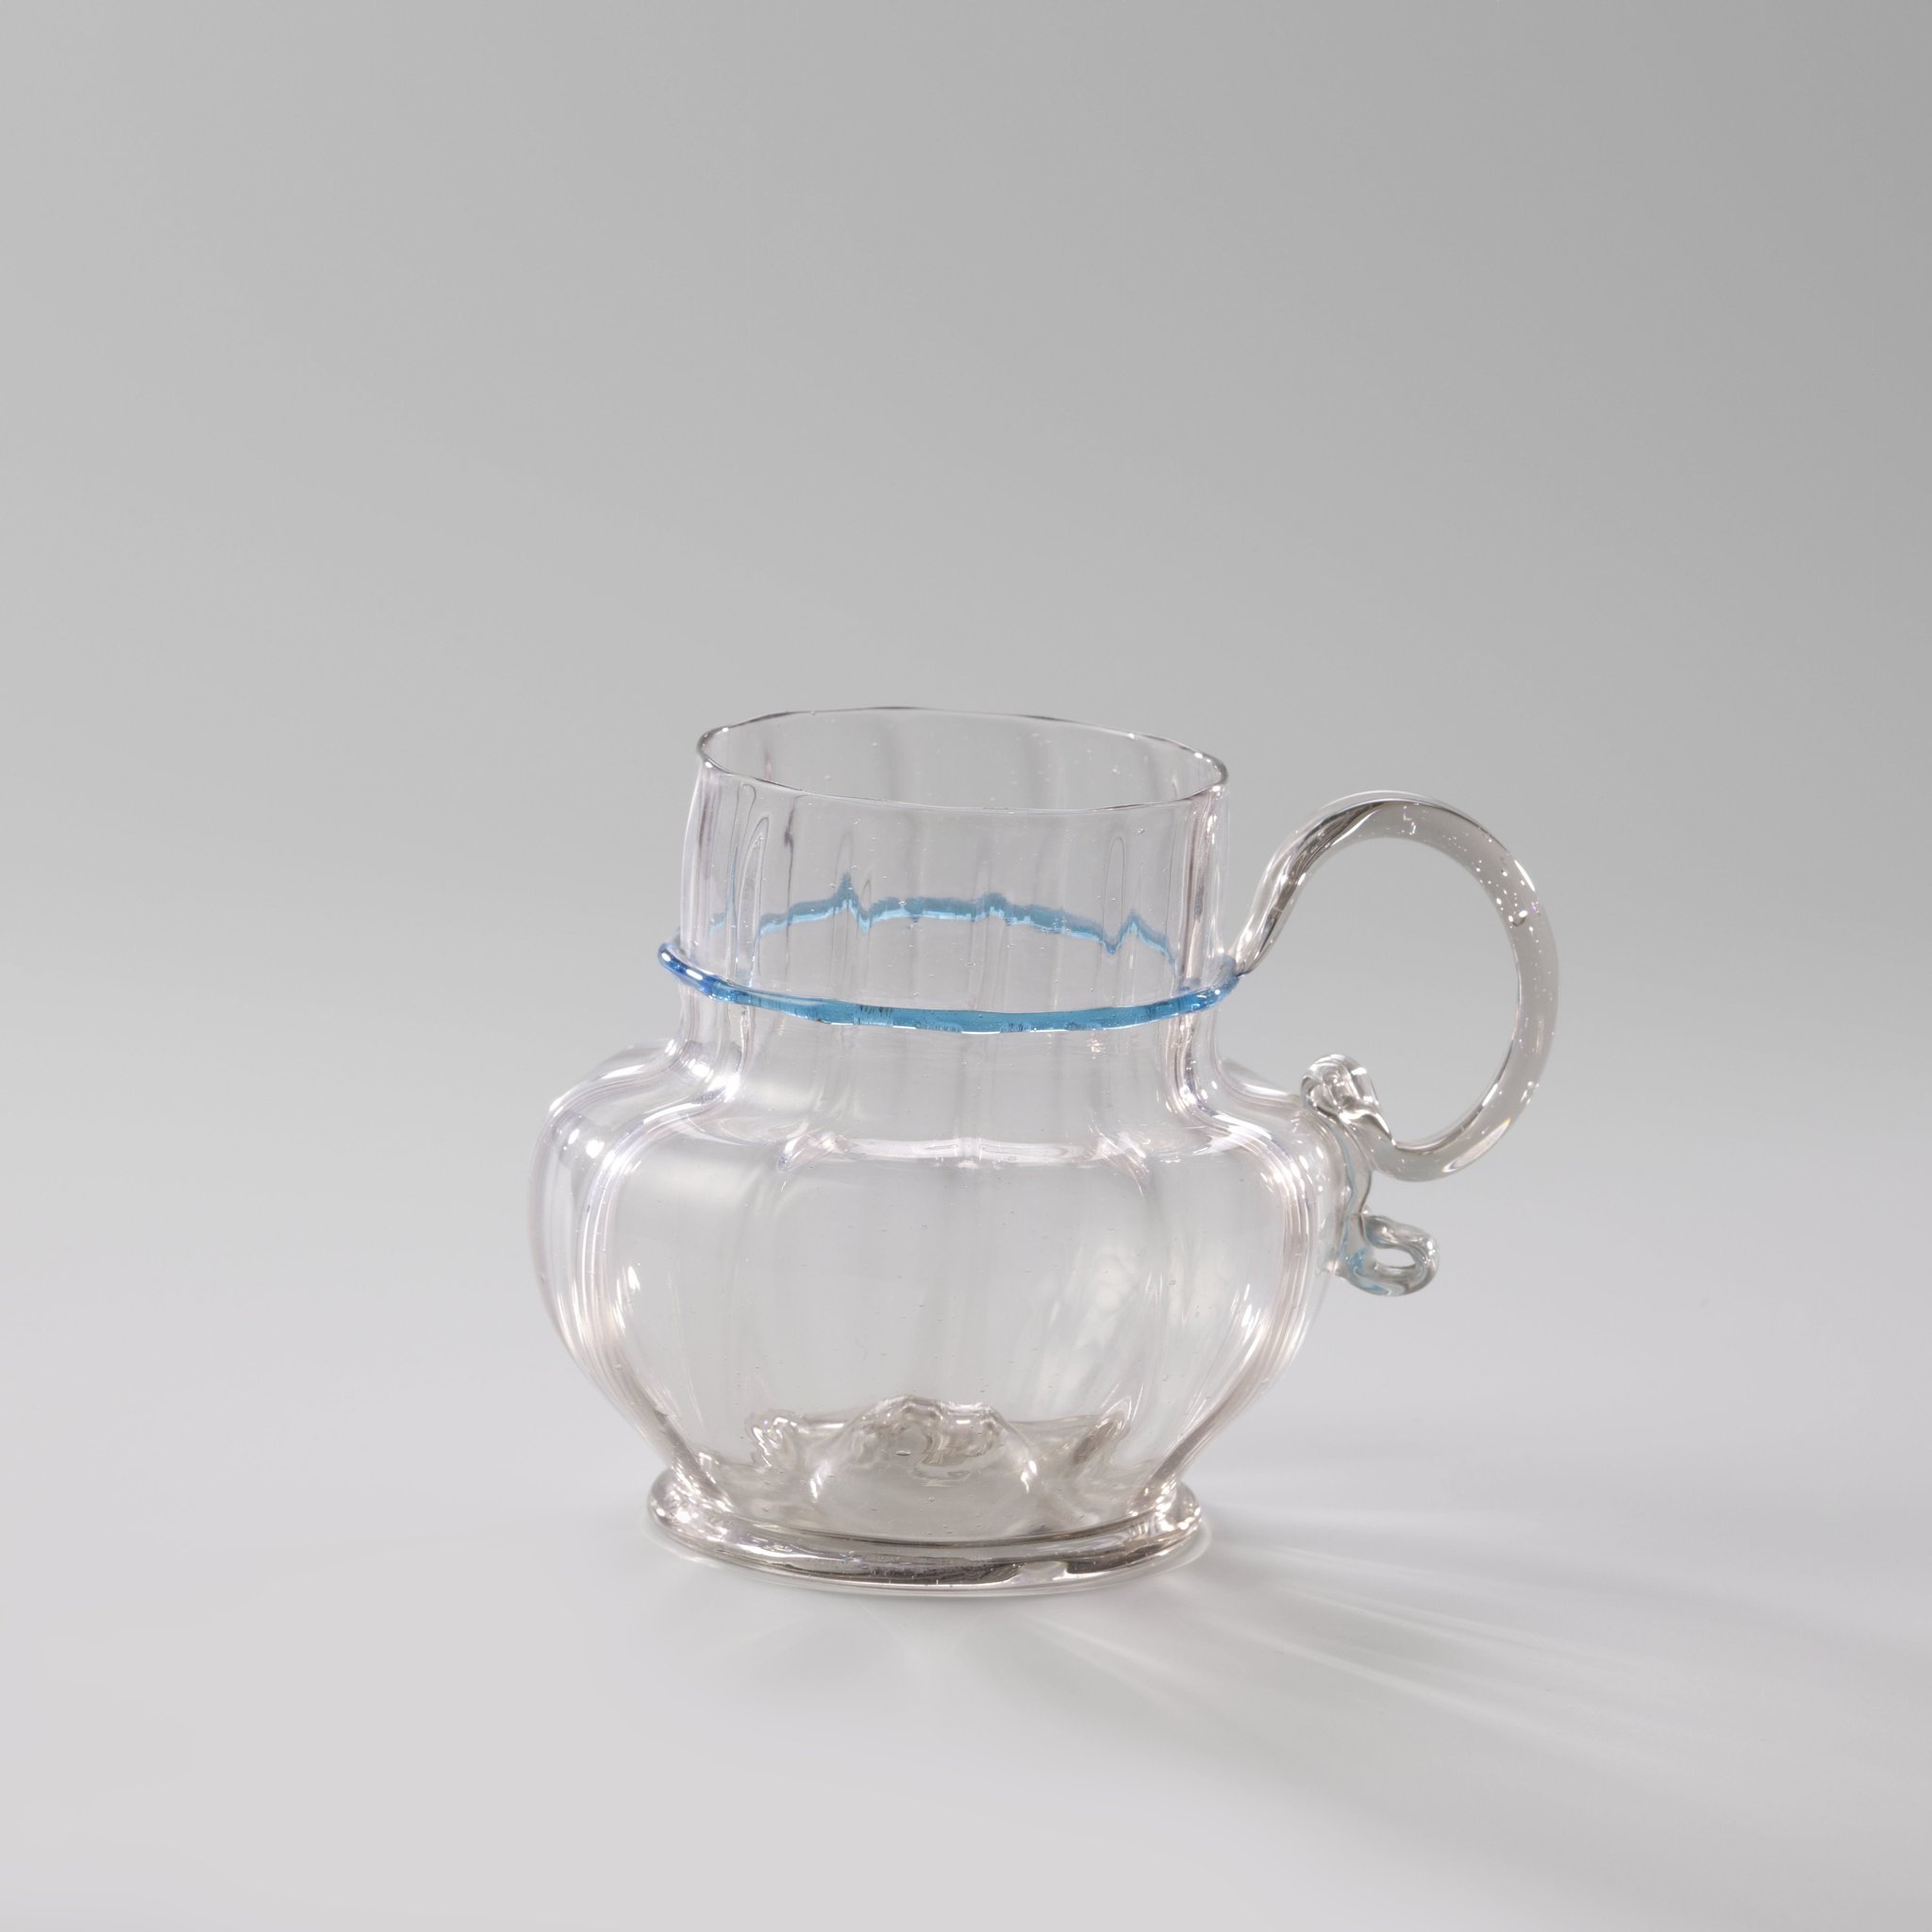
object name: stave tankard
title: Bierpul met optisch geblazen verticale ribben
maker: Anonymous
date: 1600-1700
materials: glass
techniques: façon de venise, glassblowing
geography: low countries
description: Tankard. Netherlands, façon de Venise, c. 1600-1700.